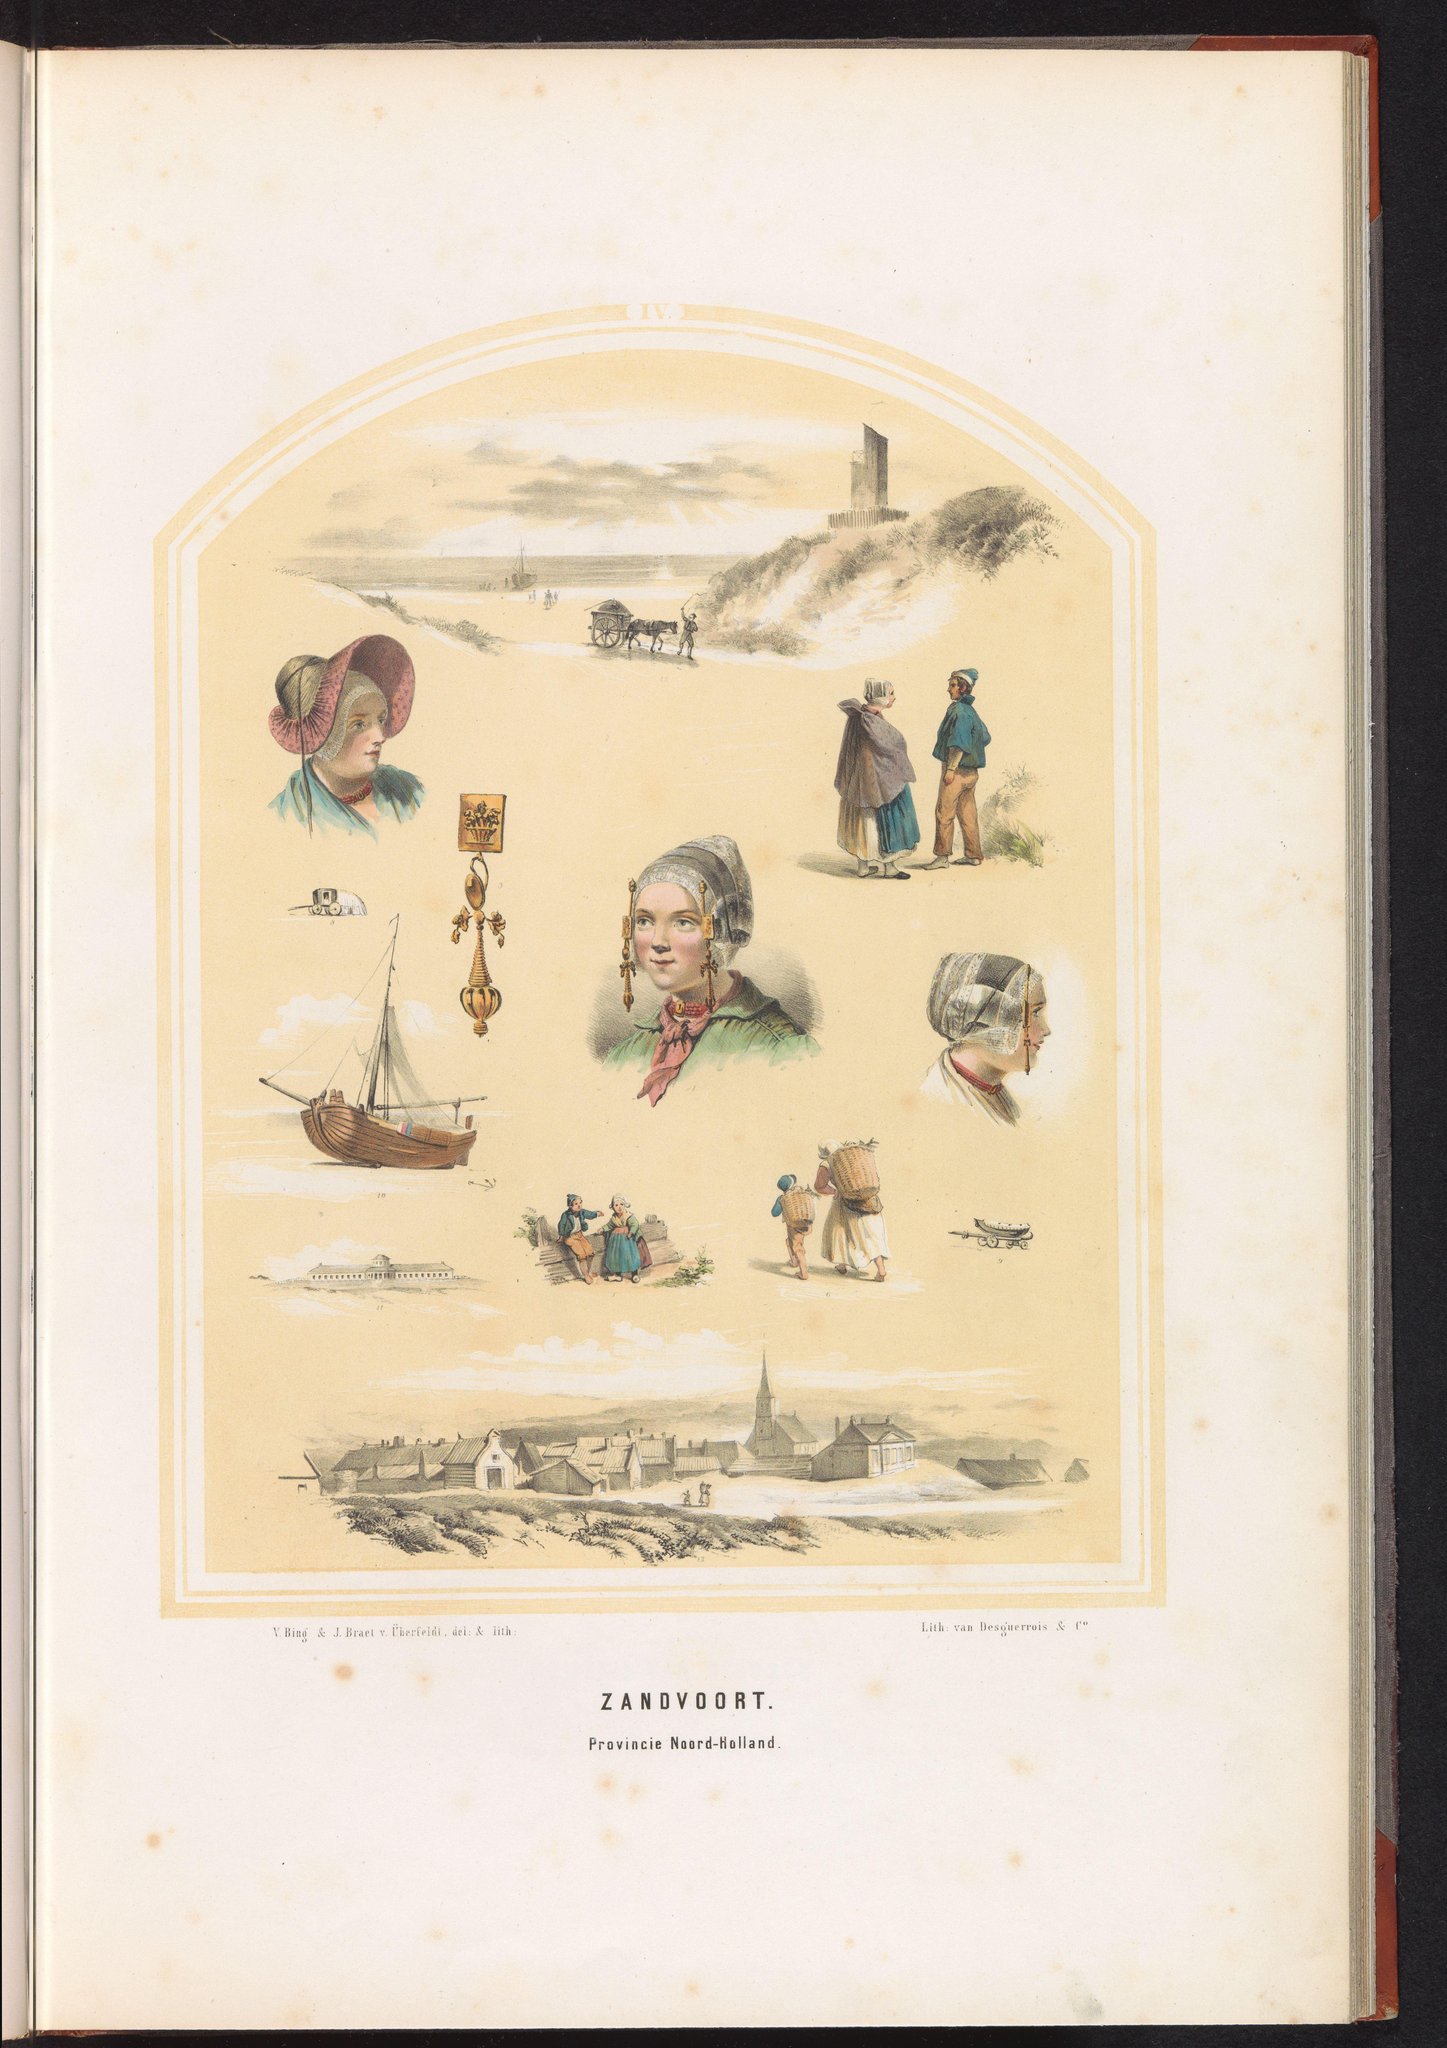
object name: print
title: Zandvoort. Provincie Noord-Holland / IV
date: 1857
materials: paper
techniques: hand coloring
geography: amsterdam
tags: folk costume, regional costume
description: Klederdracht en gezichten van de plaats Zandvoort in de provincie Noord-Holland. Een visser met twee vissersvrouwen. Illustratie in een boek uit 1857 met 56 platen van Nederlandse klederdrachten.